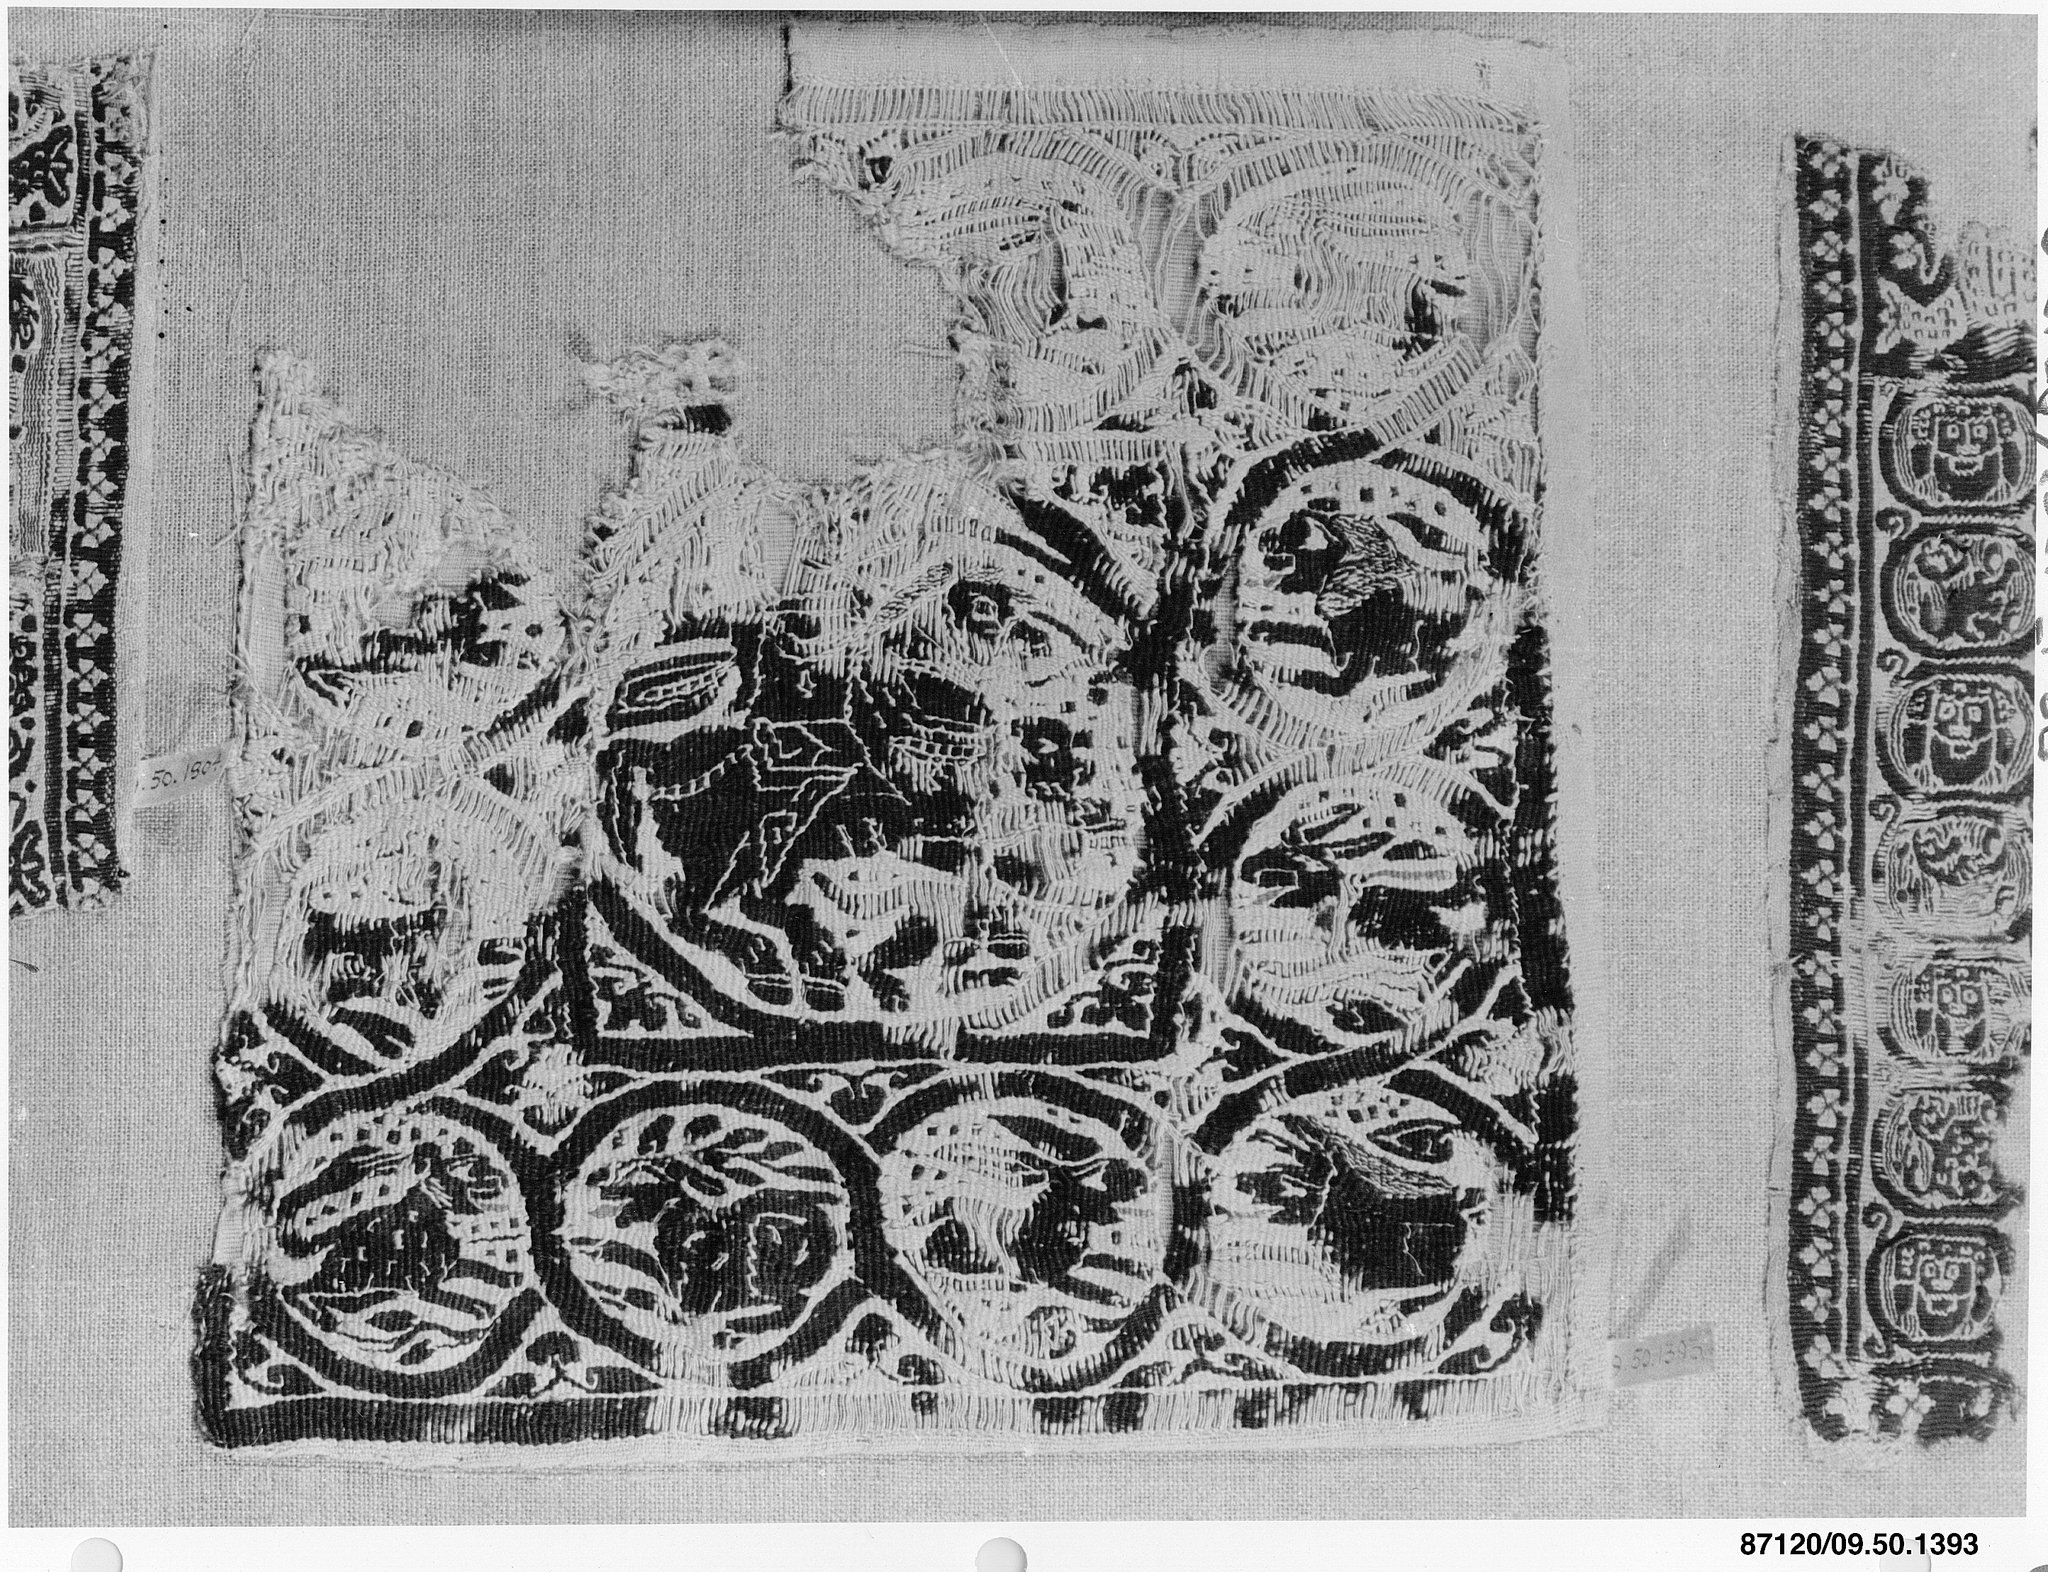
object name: square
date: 301-500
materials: linen, wool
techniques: weave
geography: egypt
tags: horses